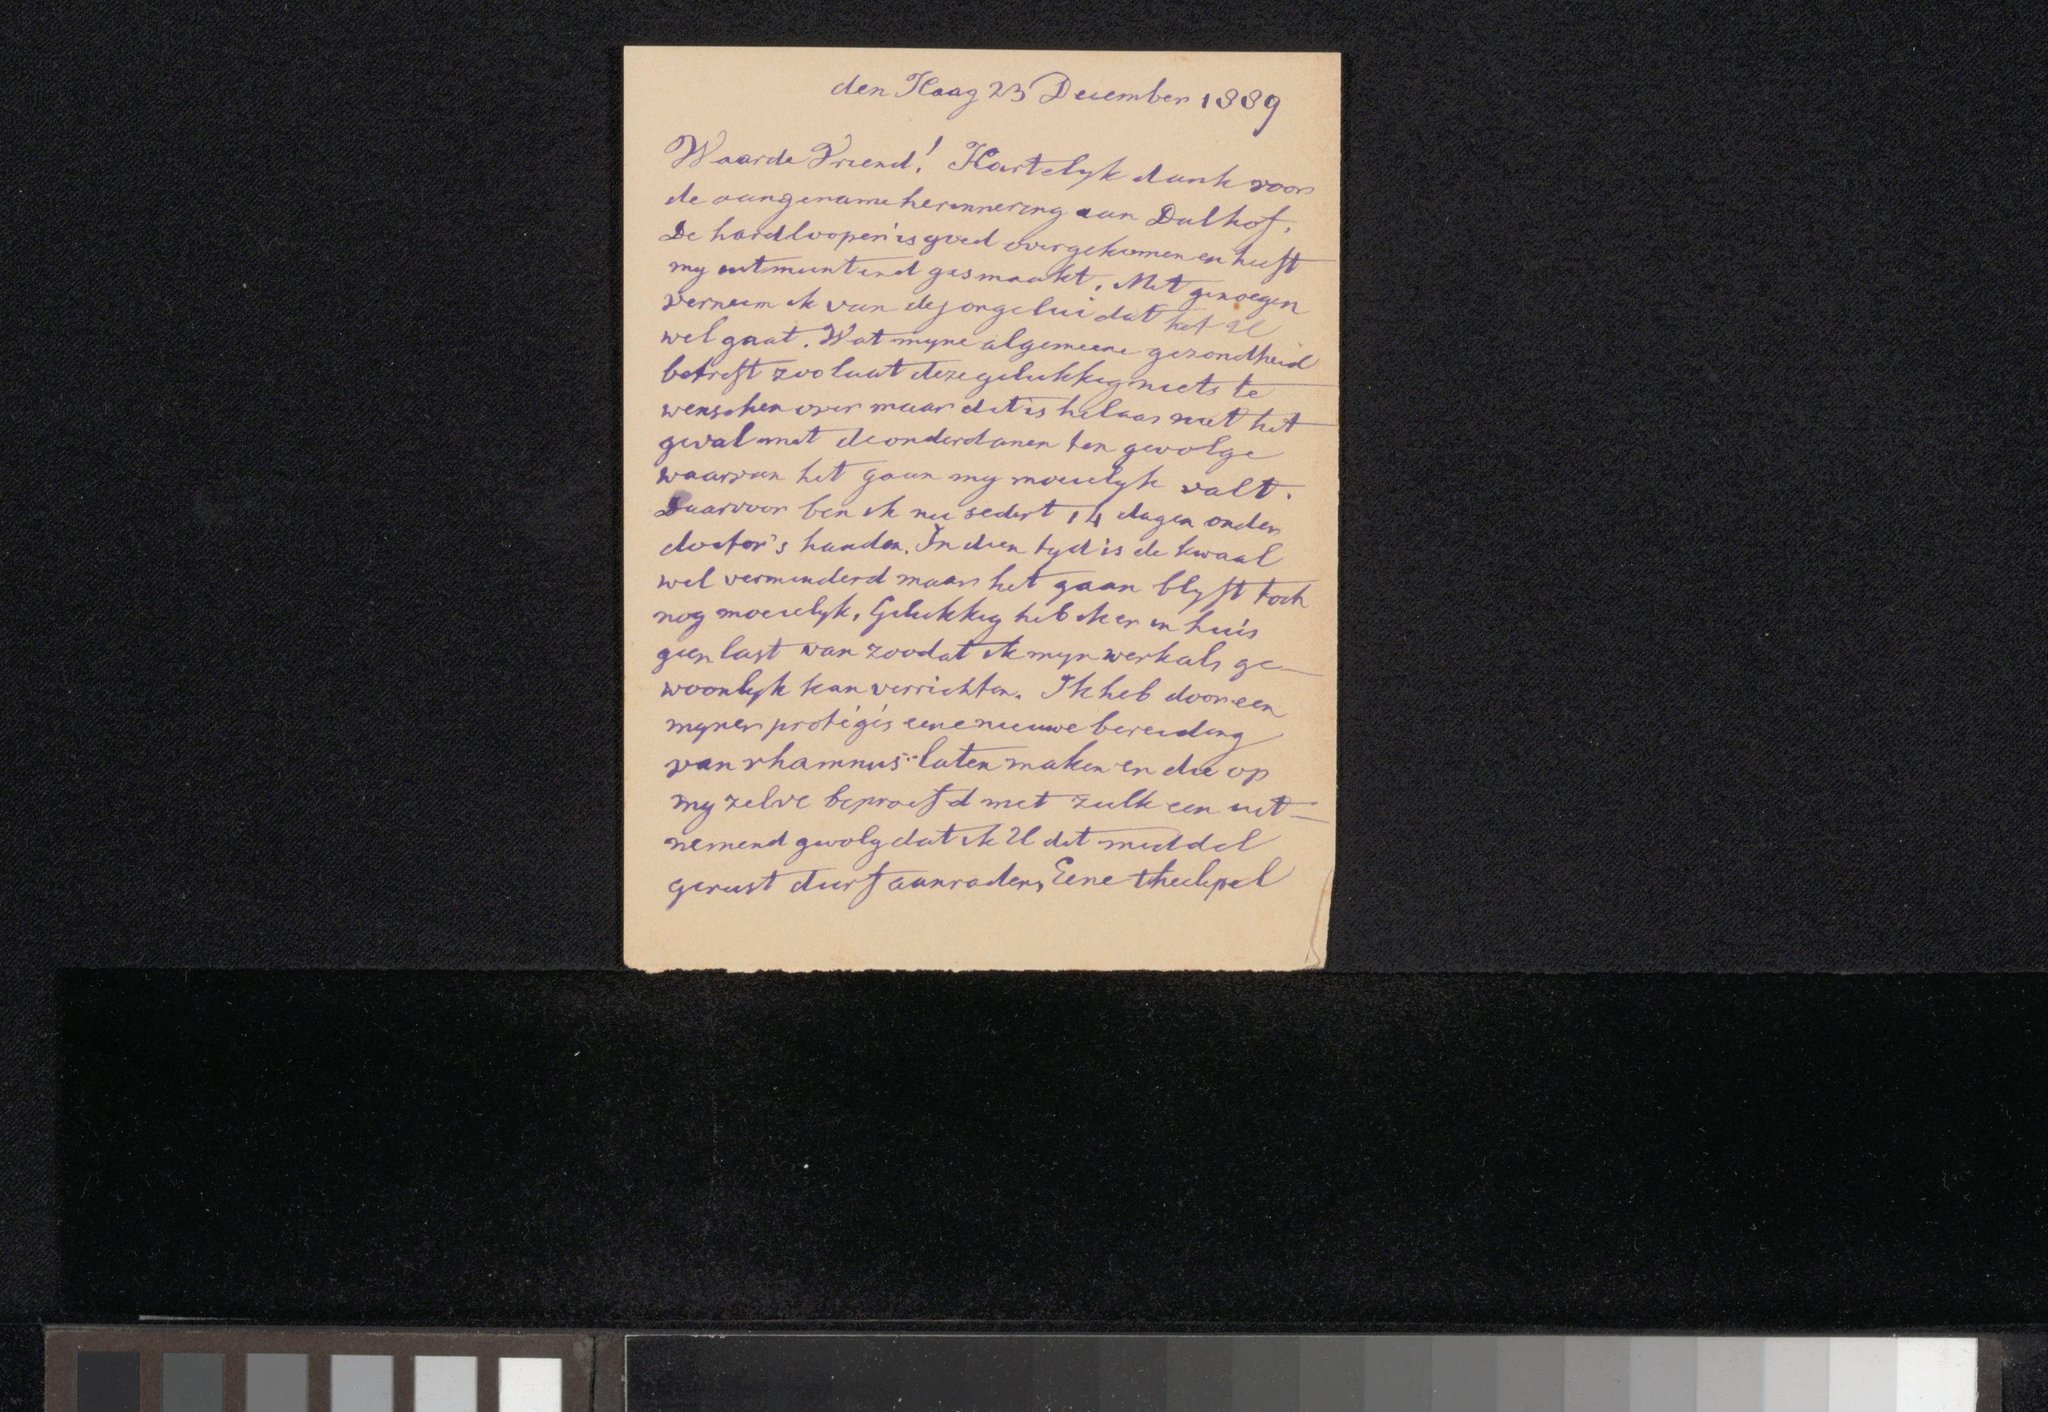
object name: letter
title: Brief aan Ary Johannes Lamme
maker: johan eliza de vrij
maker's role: scheikundige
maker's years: 1813-1898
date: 1889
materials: ink, paper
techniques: pen, writing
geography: the hague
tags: draughtsman, ary johannes lamme, diseases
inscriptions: collector's mark: Lugt 2228